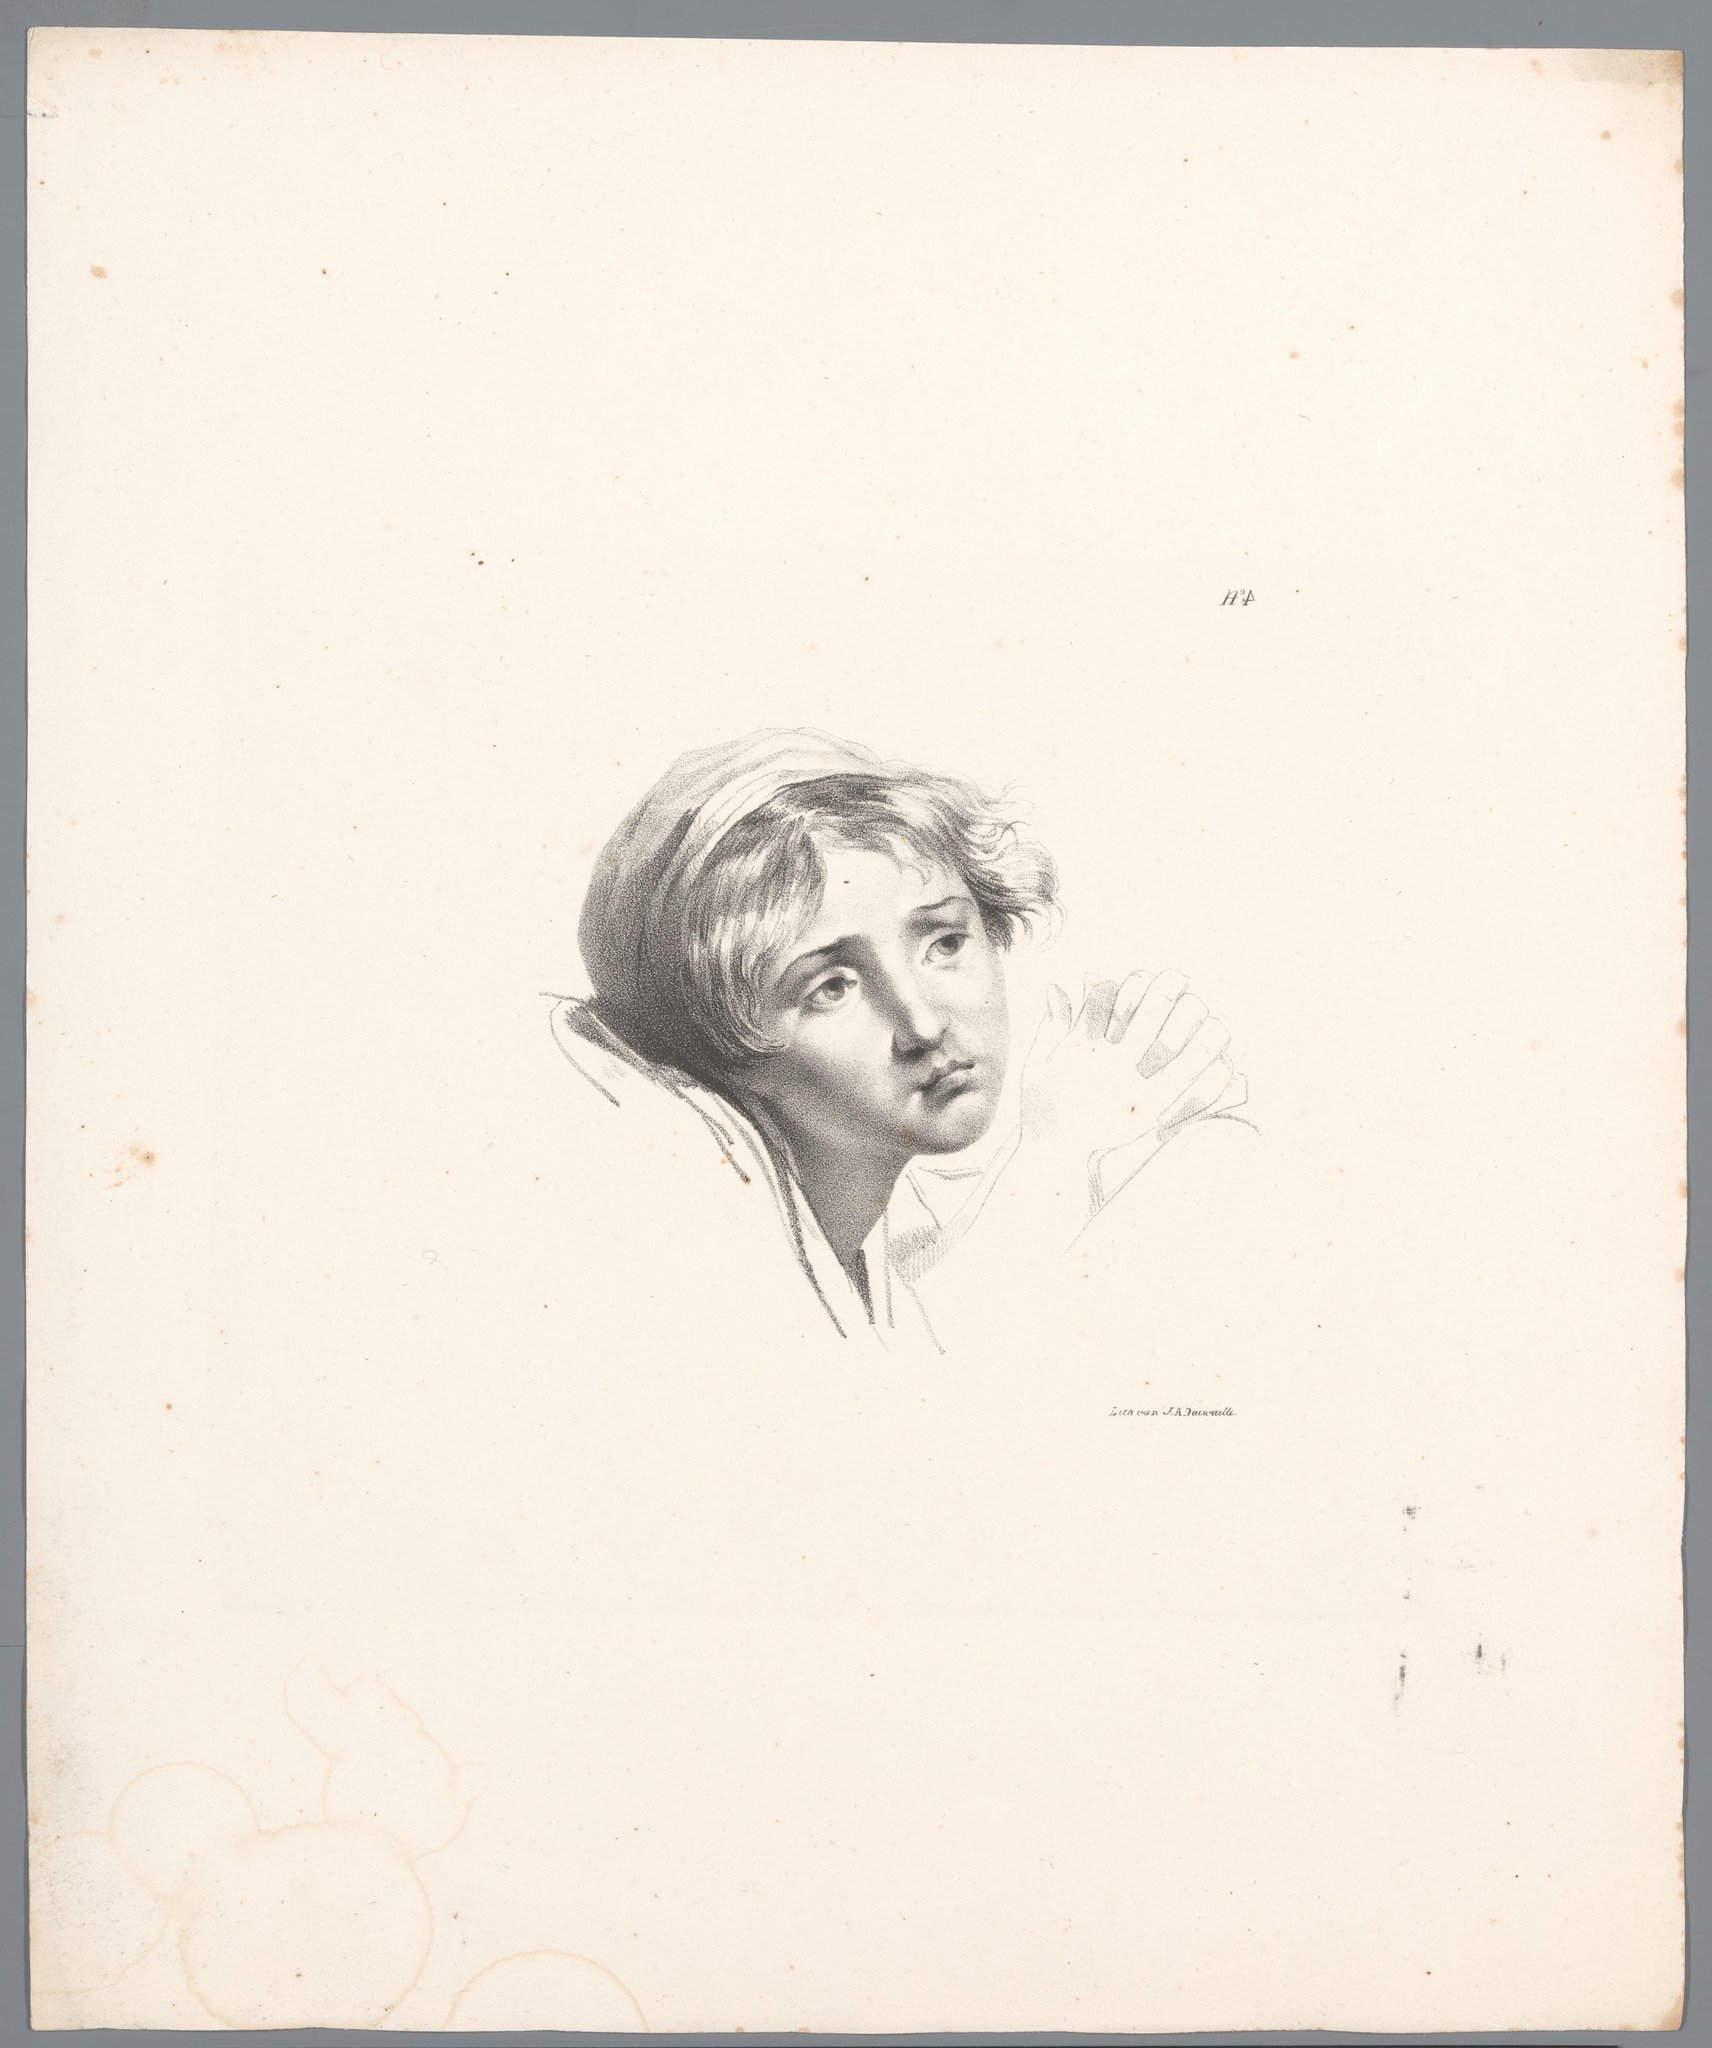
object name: print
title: Hartstochten na J.B. Greuze Nummer Twee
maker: jean augustin daiwaille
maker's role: draughtsman, print maker, printer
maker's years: 1786-1850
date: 1820-1830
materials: paper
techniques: lithograph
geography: amsterdam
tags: adolescent, young woman, maiden (+ relations with sad character (expressive connotations)), hands folded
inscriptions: collector's mark: Lugt 2228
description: 'Hartstochten na J.B. Greuze' bestaat uit twee of drie genummerde reeksen. (Sommige nummers komen drie keer voor op drie verschillende afbeeldingen.) Binnen deze omslag bevinden zich achttien verschillende afbeeldingen. Mogelijk heeft dit te maken met de twee momenten waarop Daiwaille de reeks uitgaf, ten tijden van zijn directeurschap aan de Rijksakademie in Amsterdam en daarna als zelfstandige. De omslag behoort waarschijnlijk bij een van deze twee series. Zie Marres-Schretlen in het Bulletin van het Rijksmuseum.